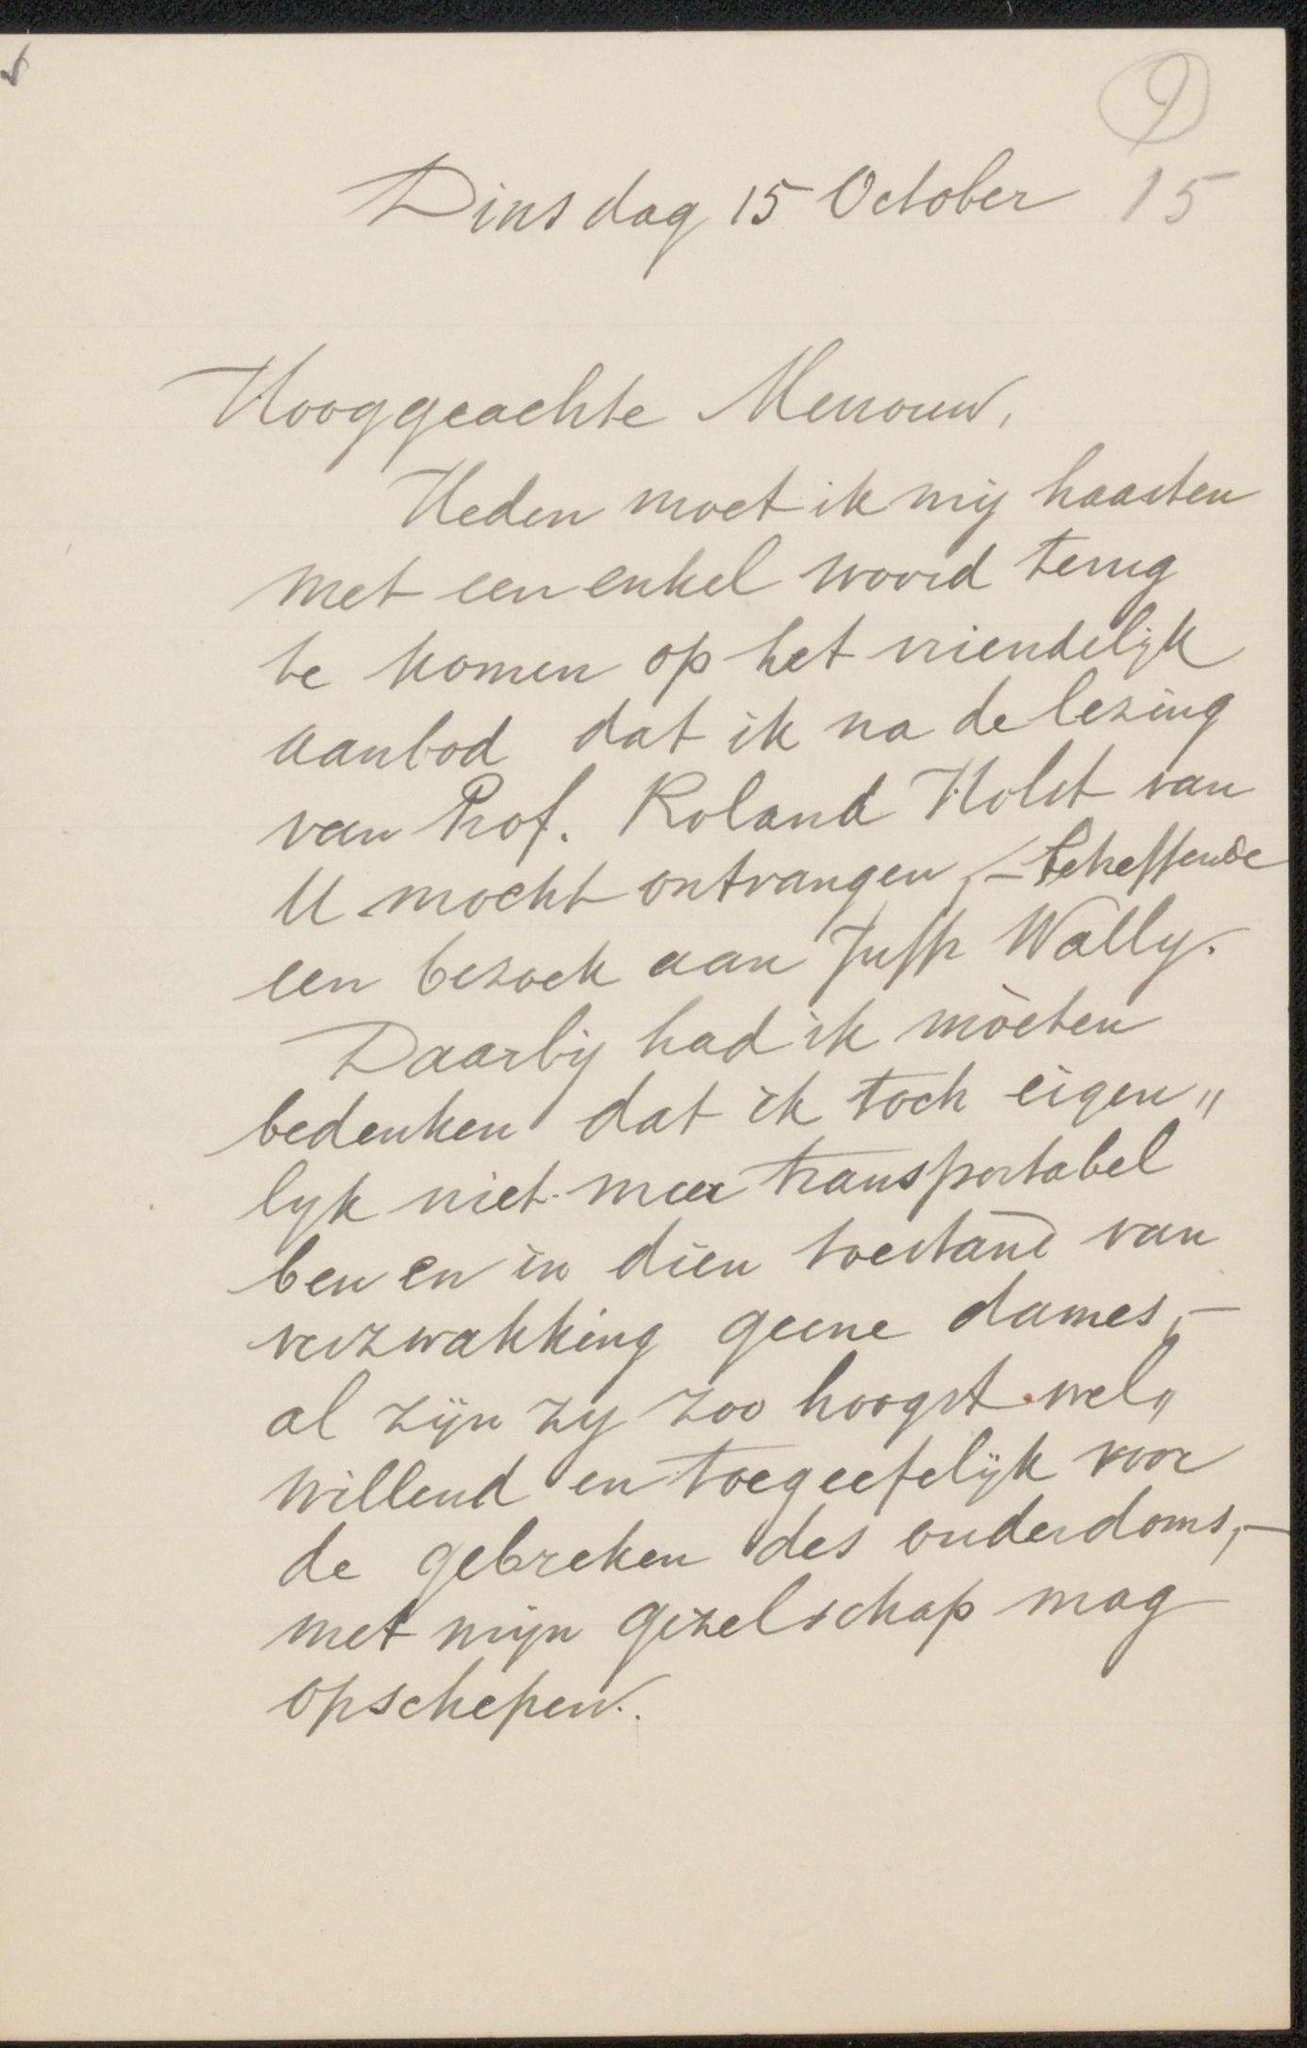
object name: letter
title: Brief aan Anna Dorothea Dirks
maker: august allebé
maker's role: draughtsman, print maker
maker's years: 1838-1927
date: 1848-1918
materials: ink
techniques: pen, writing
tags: dordrecht, painter, designer, jan veth, amsterdam, print maker, draughtsman, wally moes, artist, anna dorothea dirks, richard nicolaüs roland holst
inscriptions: collector's mark: ‘RPK’